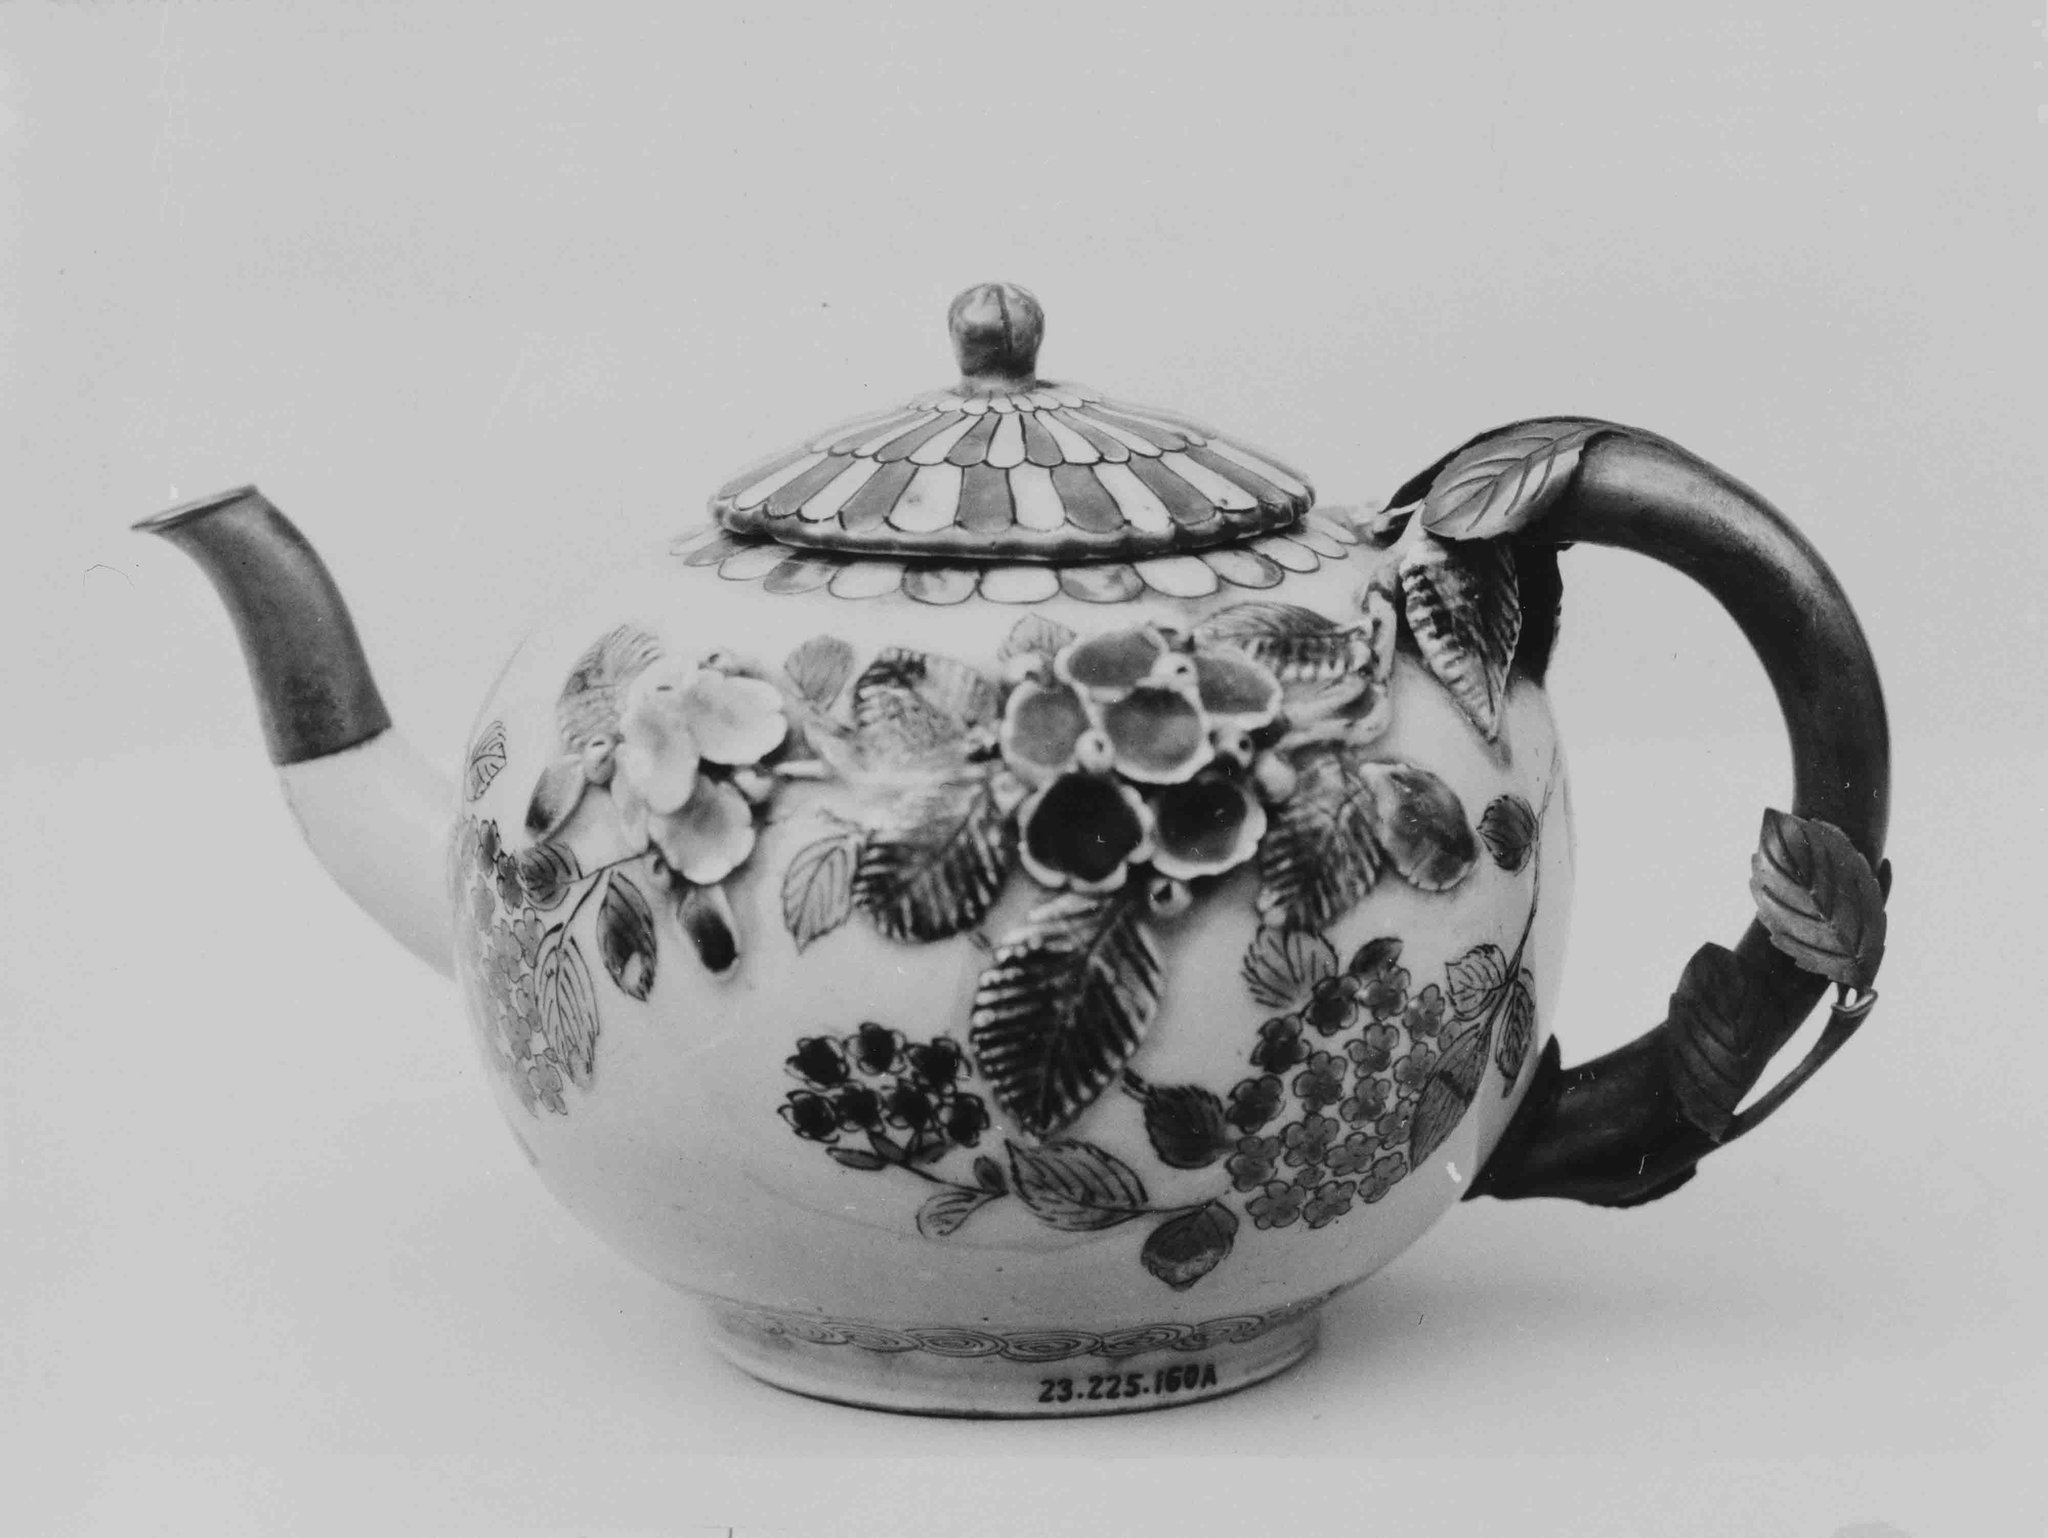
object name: teapot with cover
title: Teapot and cover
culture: japanese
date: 1780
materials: enamel, porcelain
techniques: relief